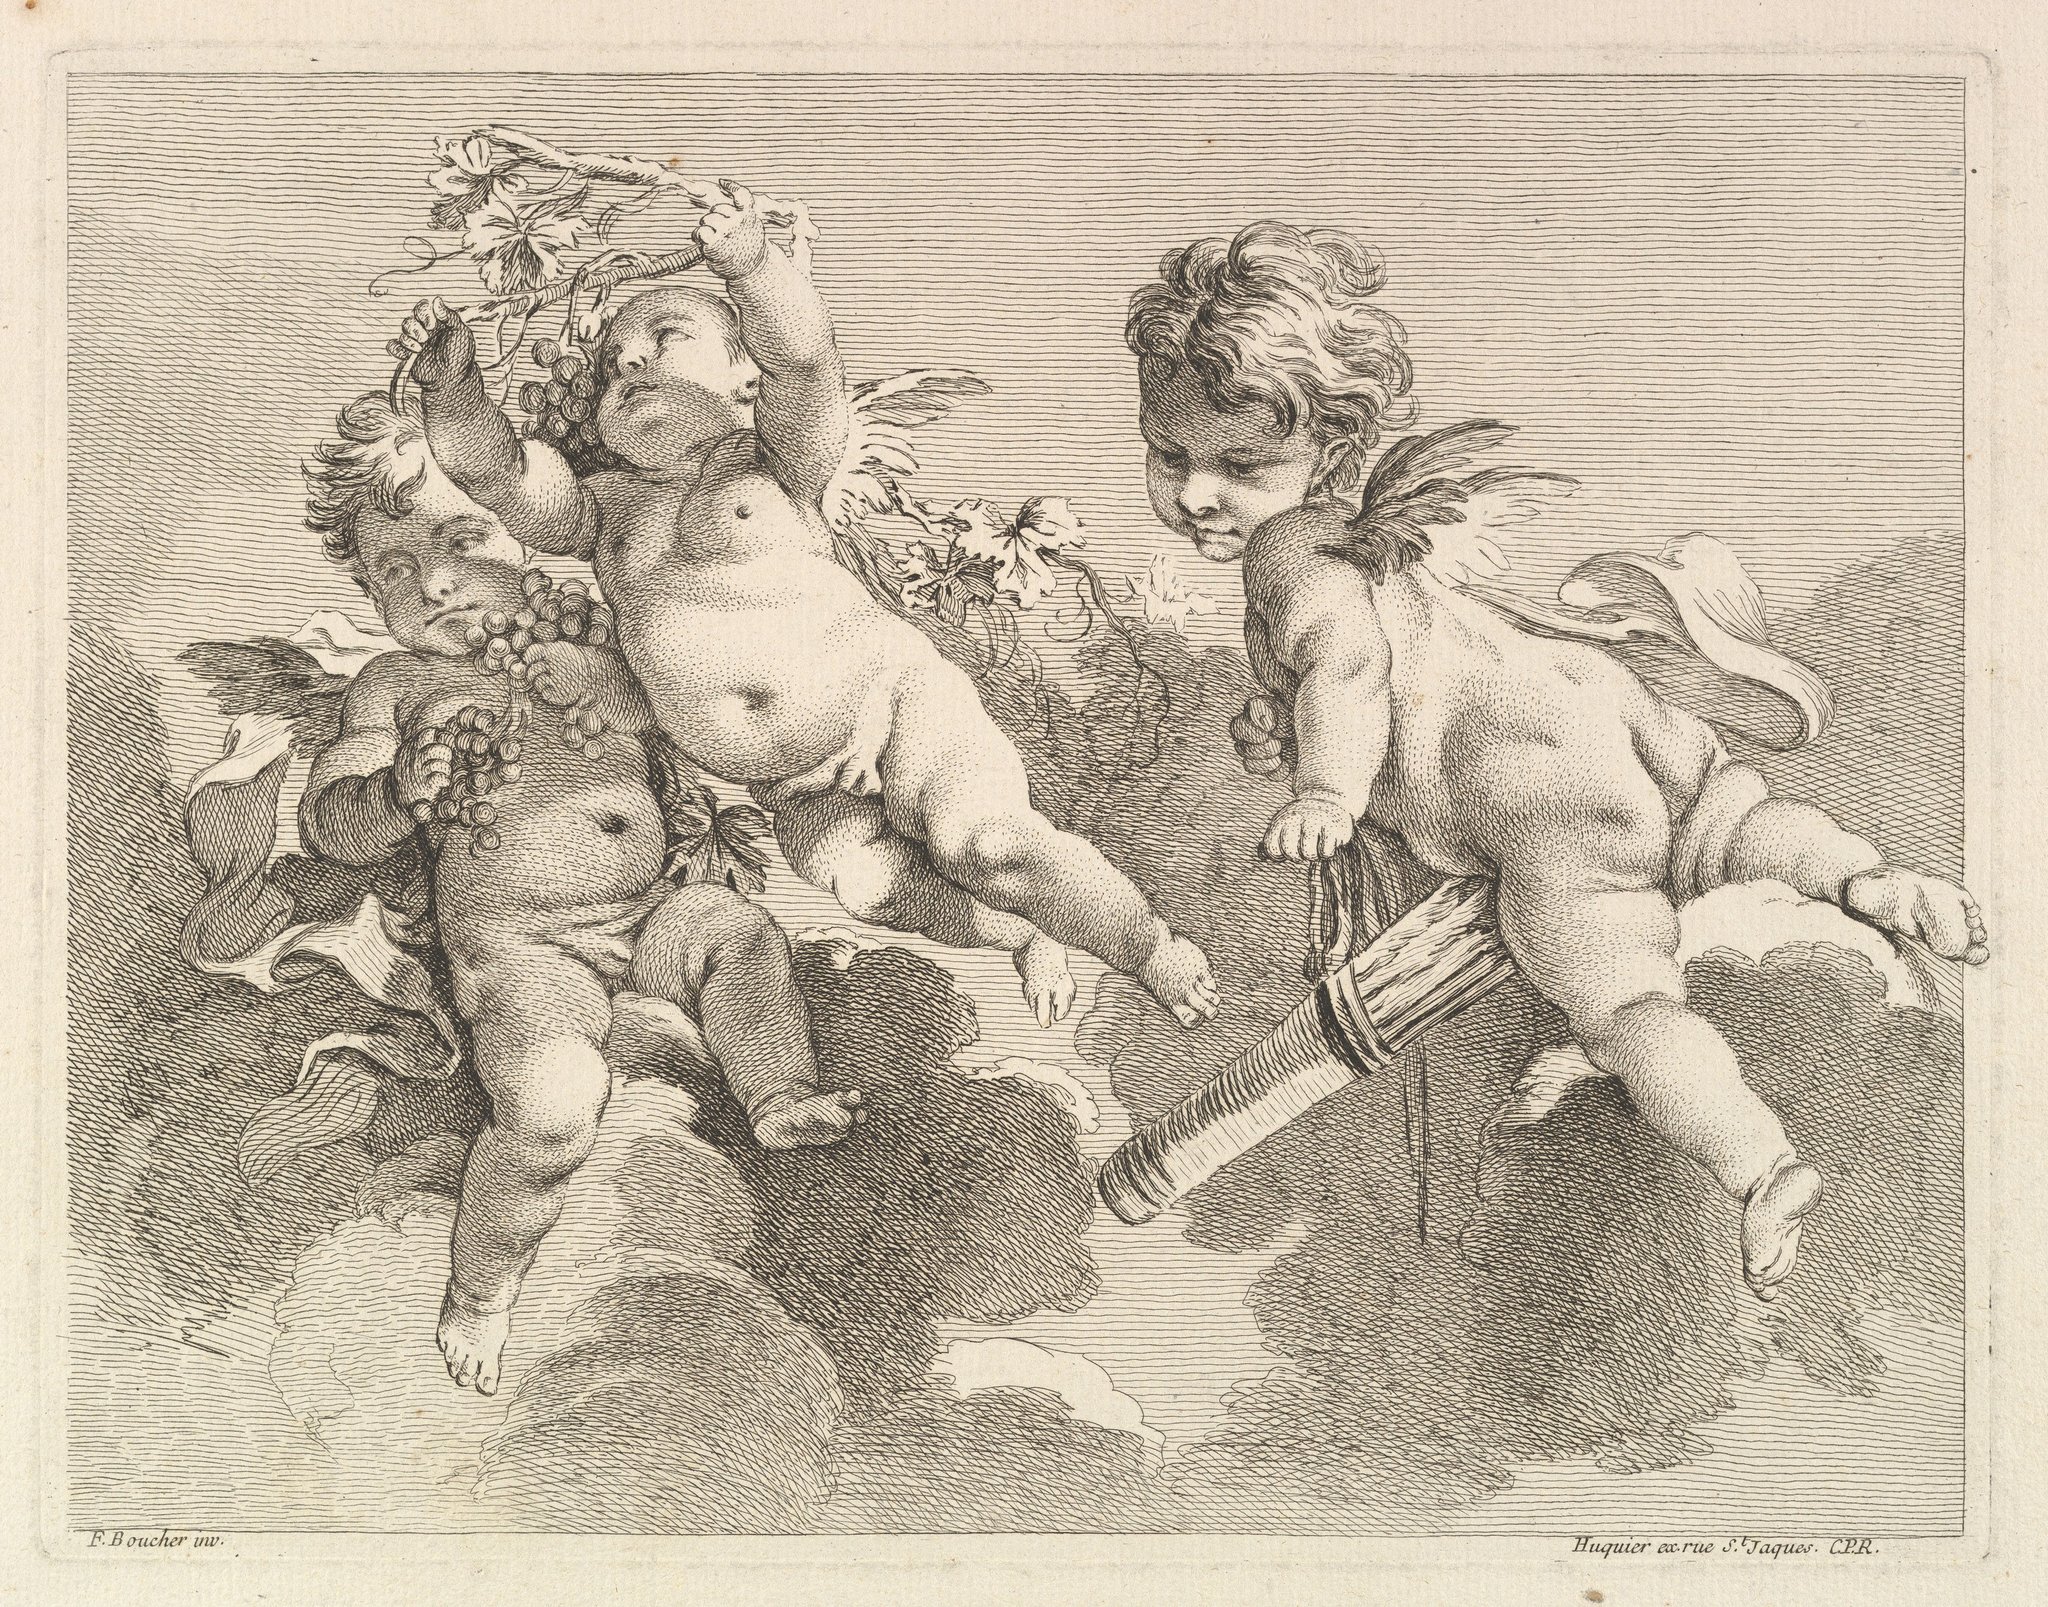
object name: print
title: Three Loves, One holding a Quiver, the Other, Grapes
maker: pierre alexandre aveline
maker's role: artist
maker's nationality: french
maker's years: 1702-1760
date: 1727-1760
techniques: engraving, etching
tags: grapes